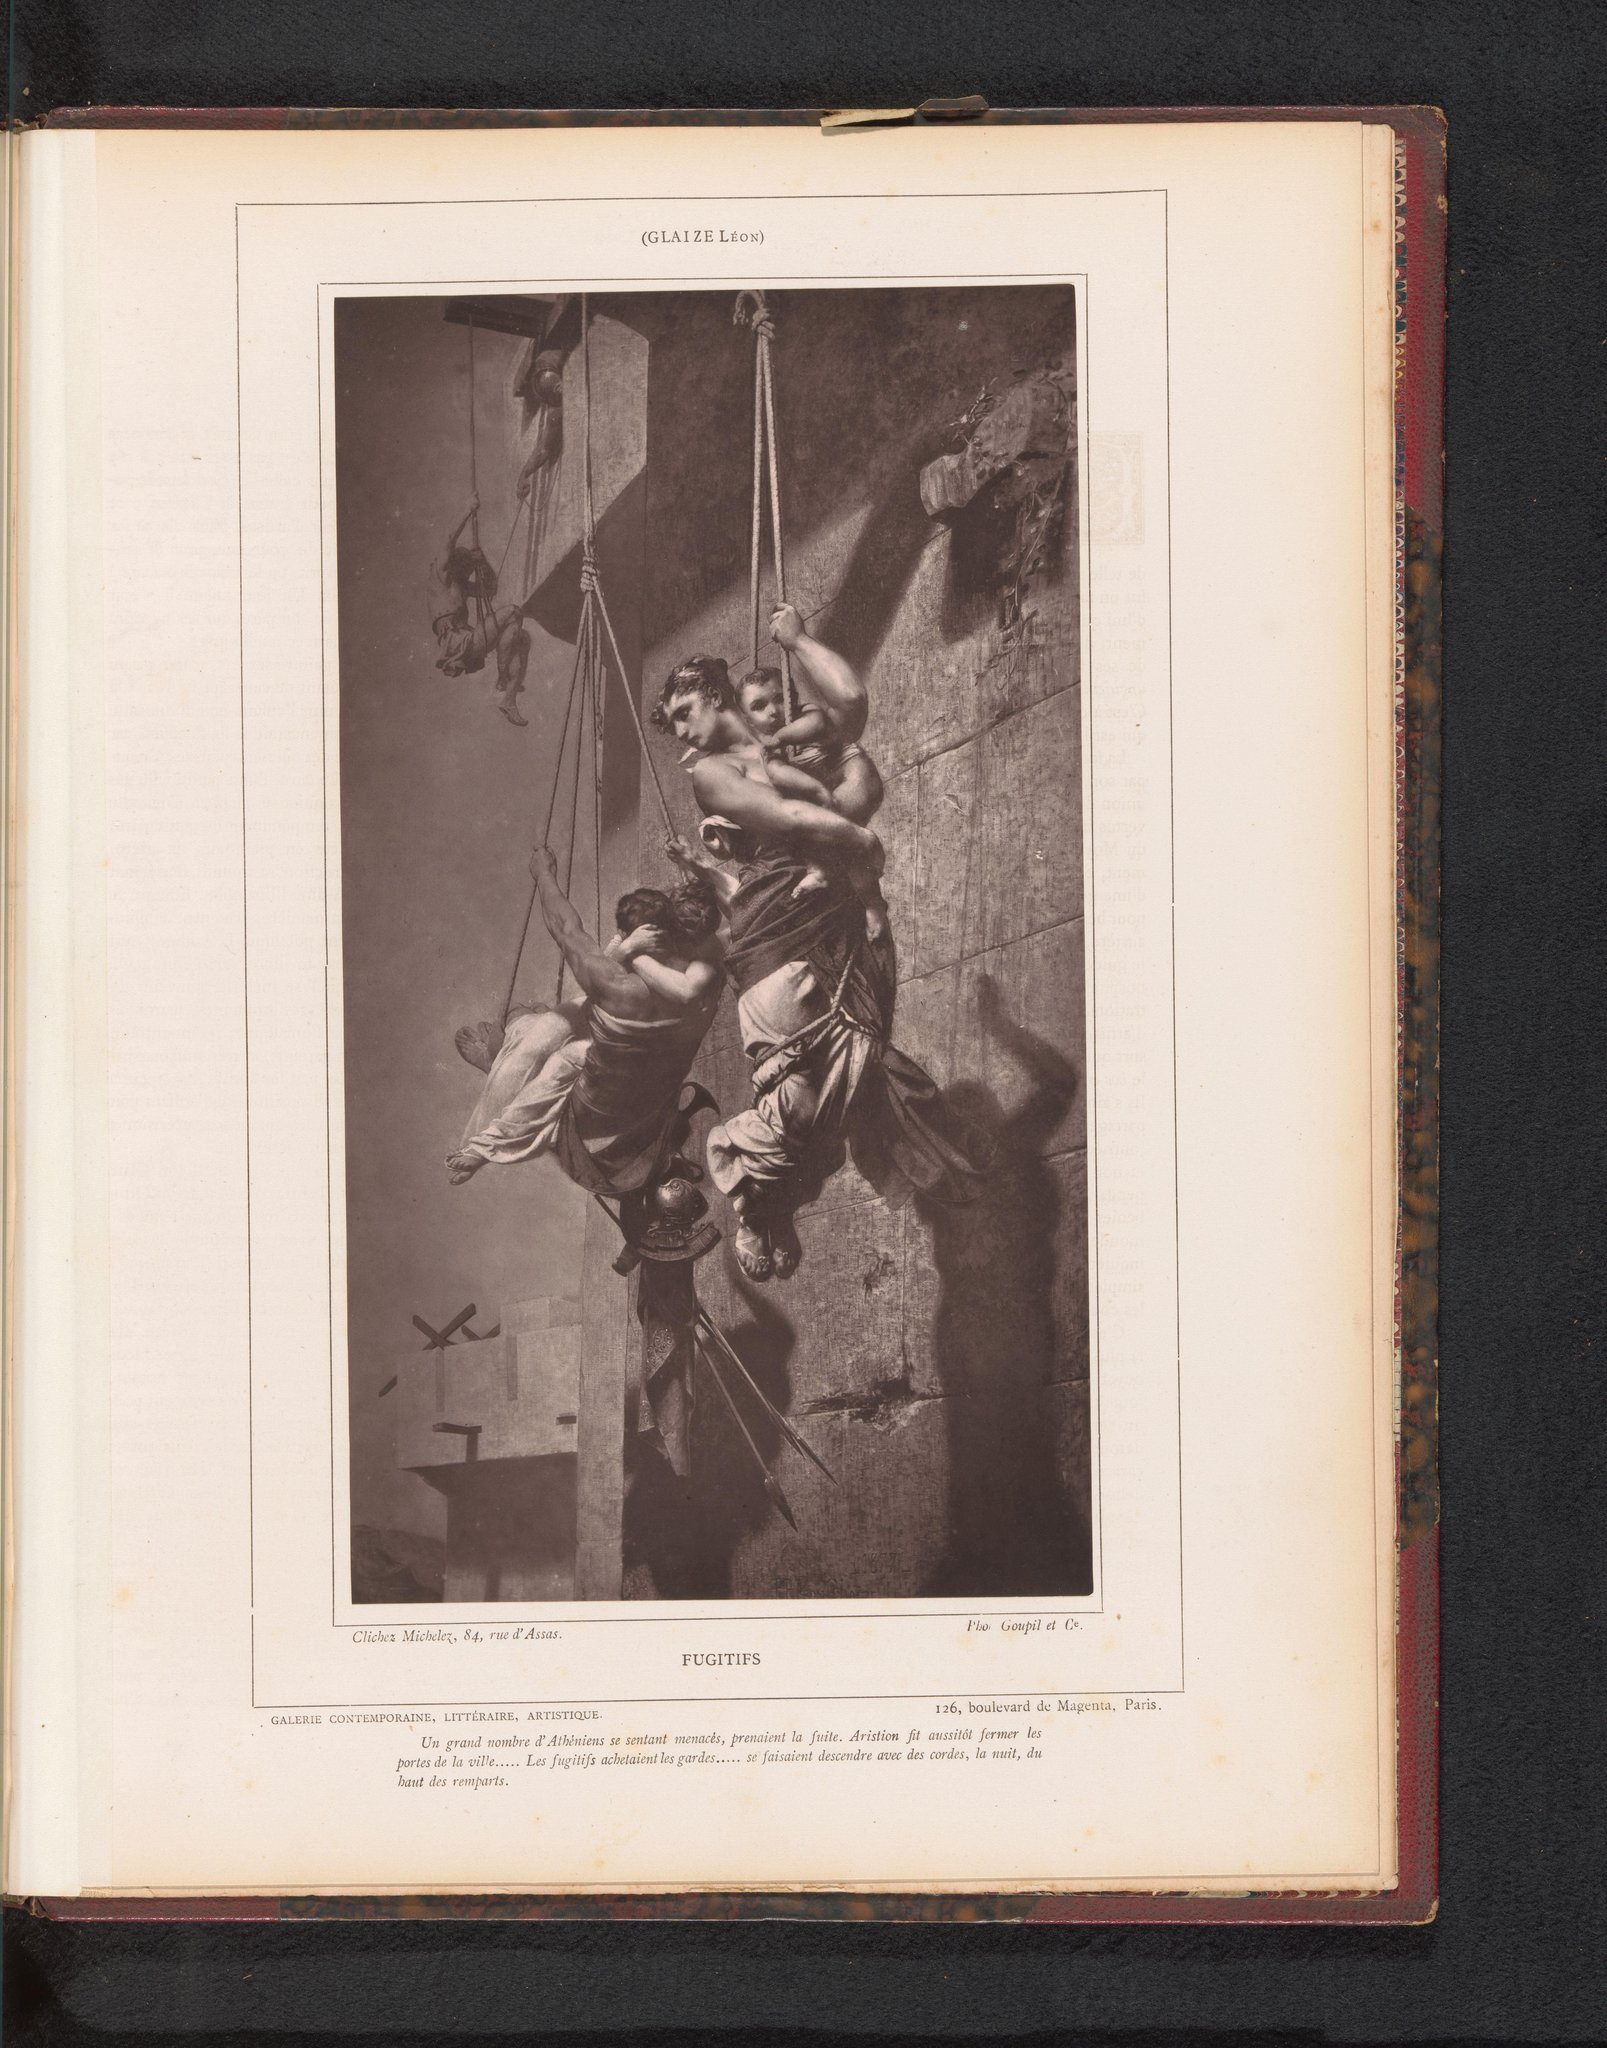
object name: reproduction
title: Reproductie van Fugutifs door Pierre-Paul-Léon Glaize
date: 1871-1876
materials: paper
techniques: woodburytype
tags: painting, drawing and the graphic arts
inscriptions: inscription: ‘(Glaize, Léon)/ Galerie Contemporaine, Littéraire et Artistique/ 126, boulevard de Magenta, Paris./ Un grand nombre d'Atheniens se sentant menacés (...)’